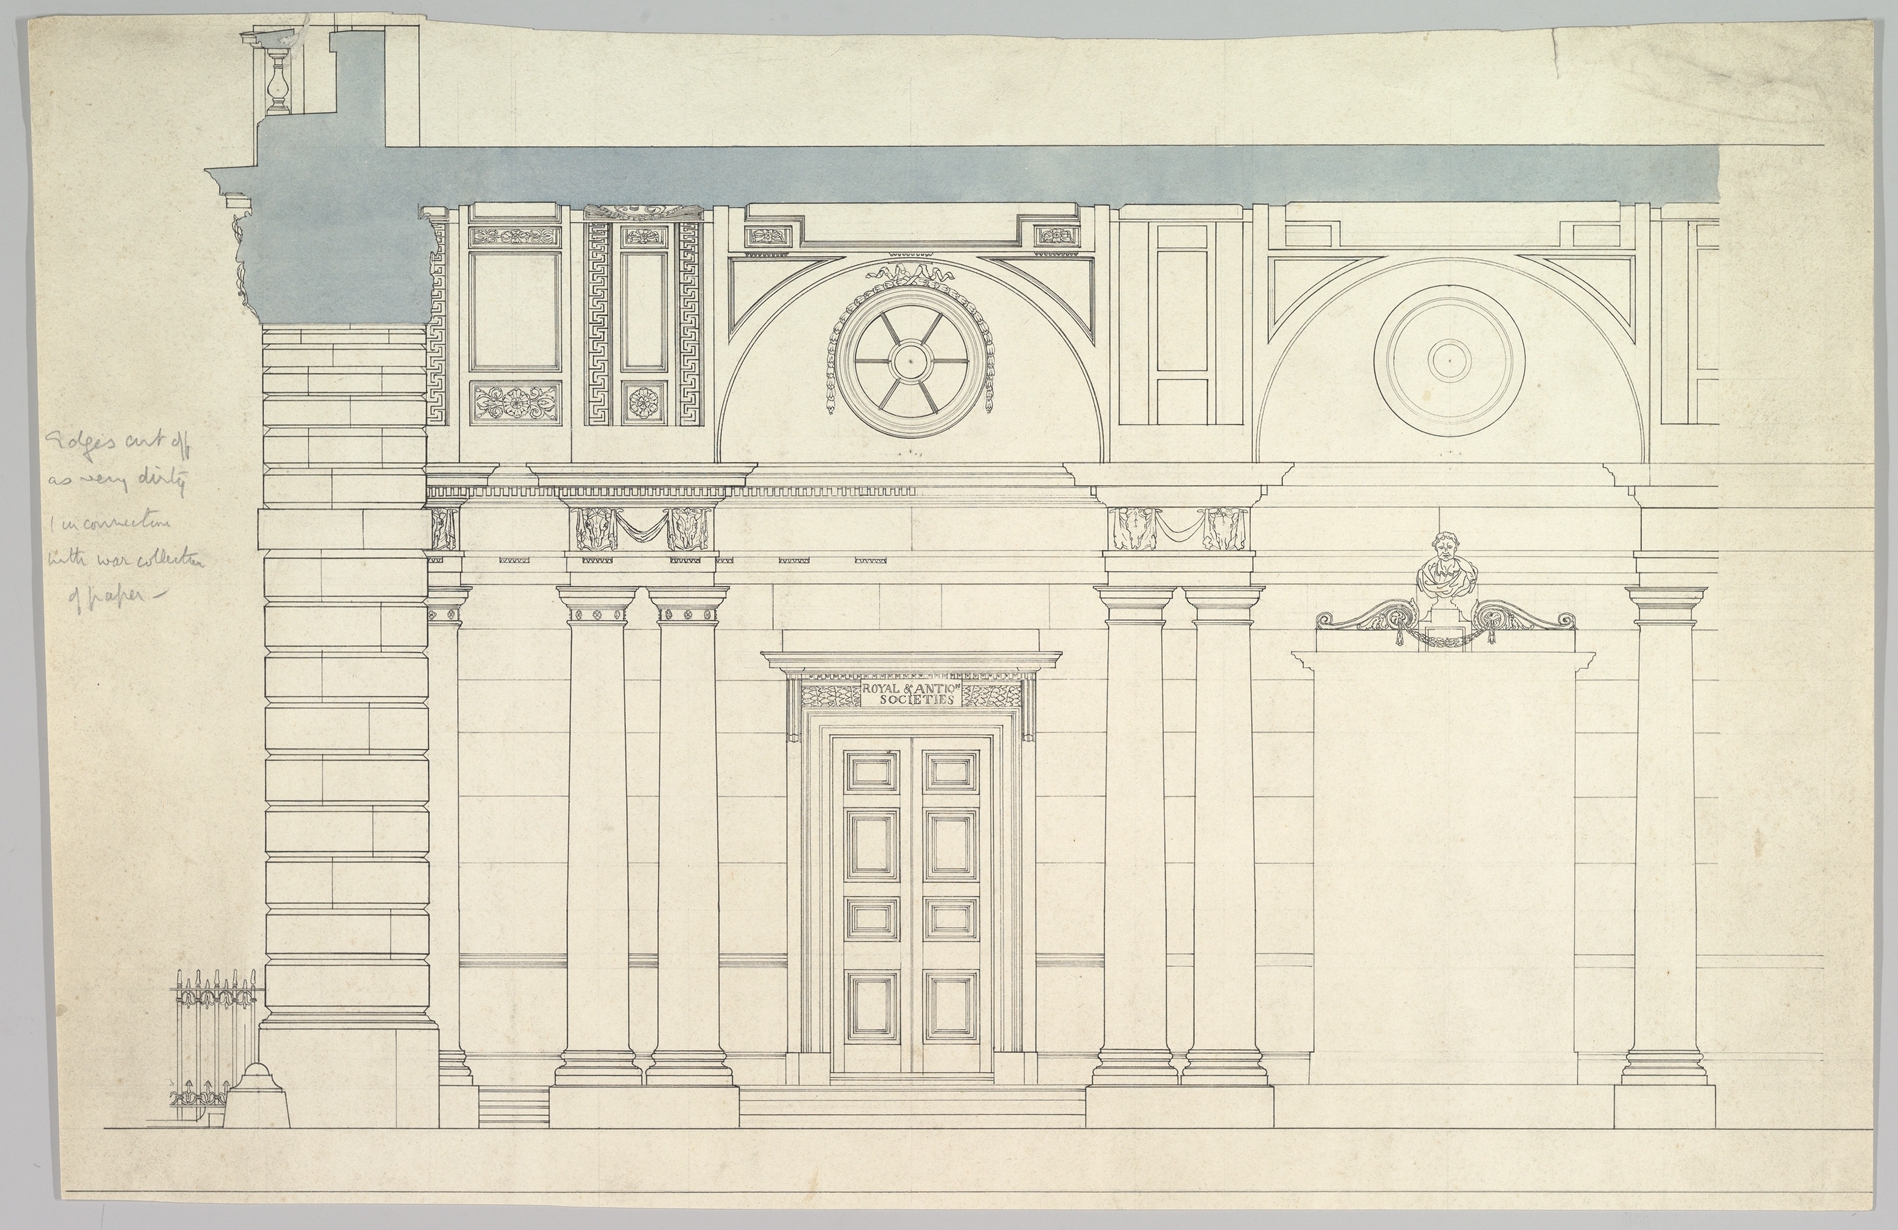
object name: drawing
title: Somerset House, London: Interior Section with Paired Columns and Arched Ceiling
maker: anonymous, british, 19th century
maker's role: artist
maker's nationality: british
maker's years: 1800-1900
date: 1801-1900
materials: graphite, ink, watercolor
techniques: pen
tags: architecture,houses